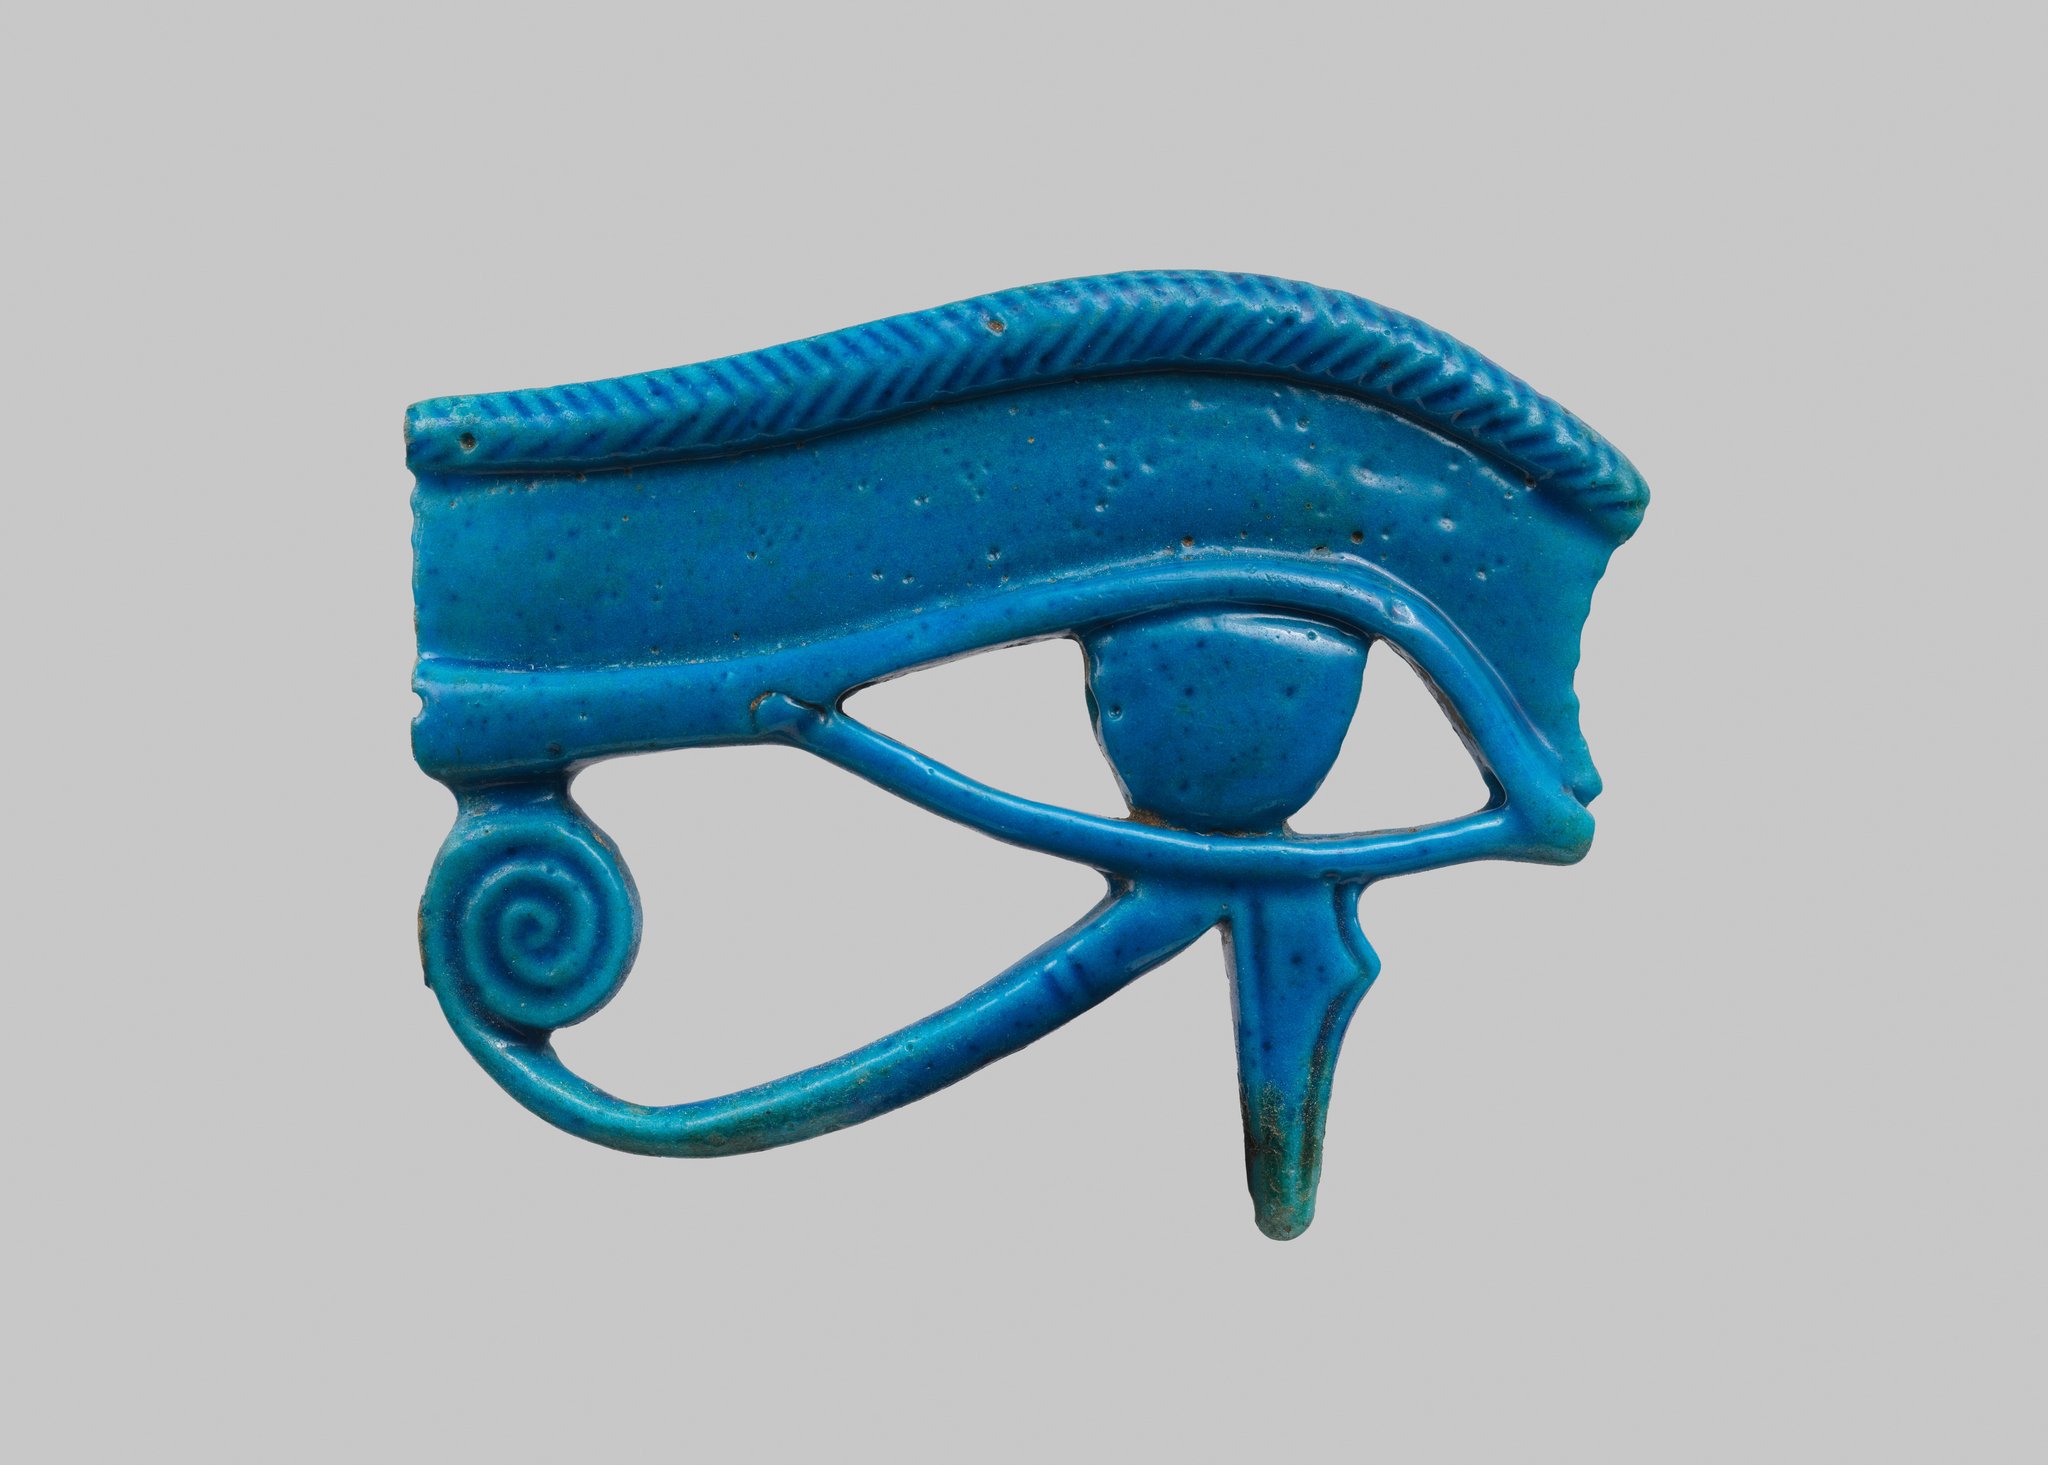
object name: amulet, wedjat eye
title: Wedjat eye amulet from a bracelet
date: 1550-1070 BCE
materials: faience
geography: egypt